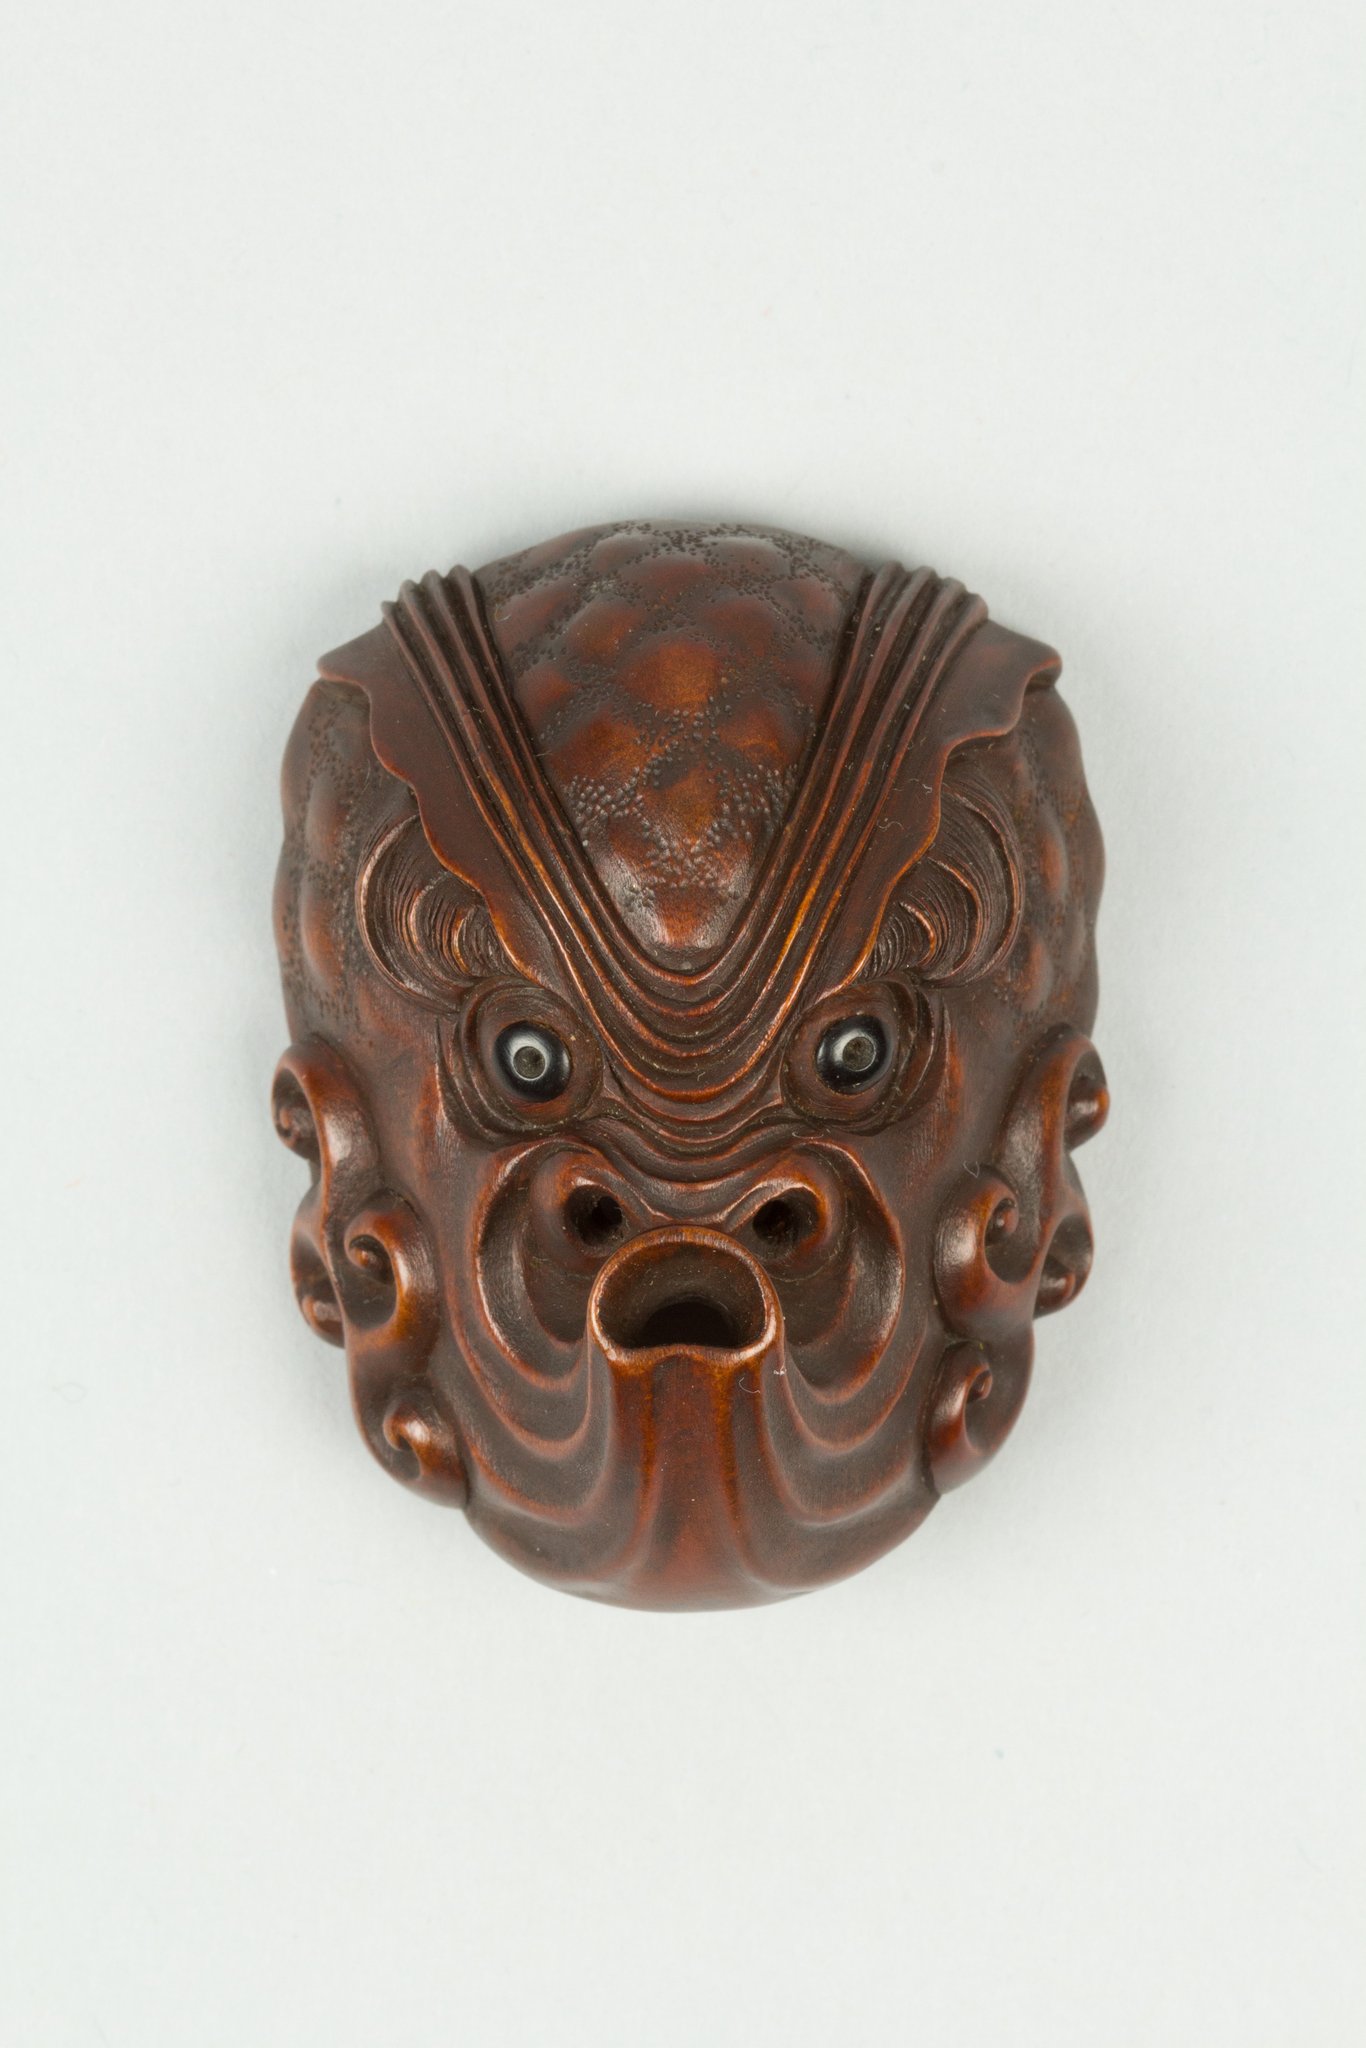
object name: netsuke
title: Netsuke of Mask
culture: japanese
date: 1801-1900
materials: wood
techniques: inlay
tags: masks